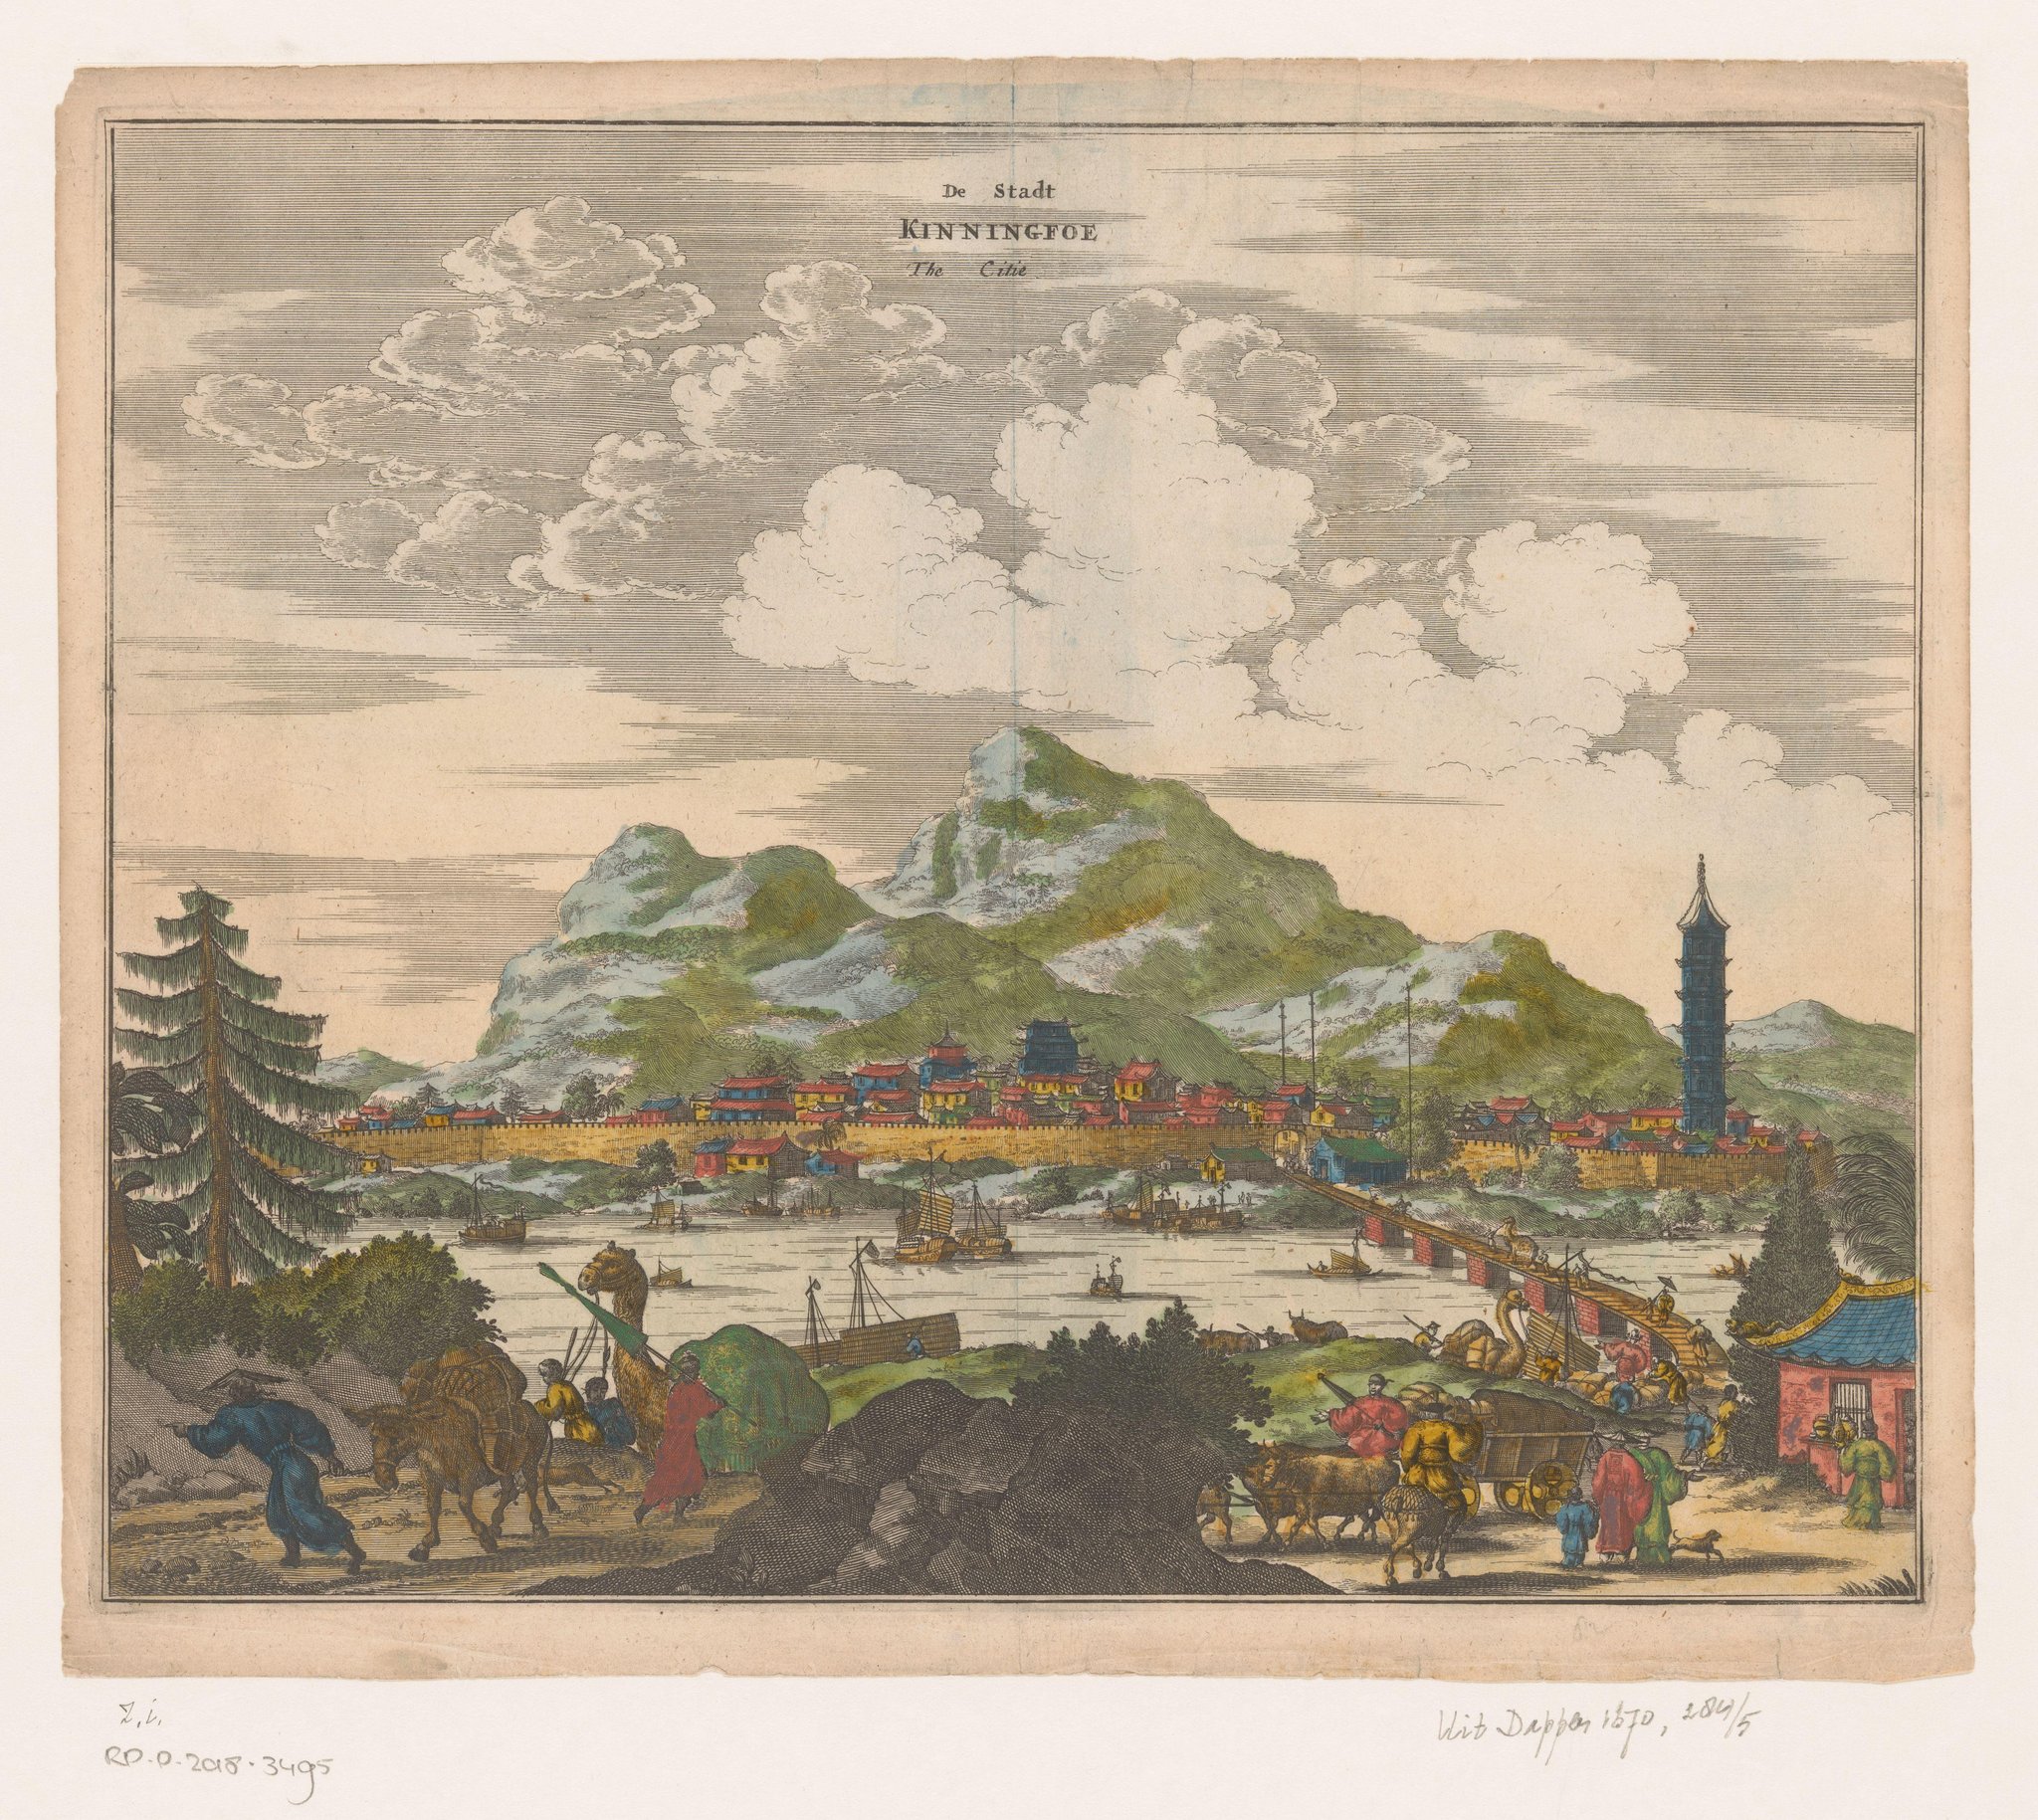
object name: book illustration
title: De stadt Kinningfoe / the Citie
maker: jacob van meurs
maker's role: draughtsman, print maker, publisher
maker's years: 1619-1680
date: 1670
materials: paper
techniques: engraving, hand coloring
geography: amsterdam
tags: prospect of city, town panorama, silhouette of city, china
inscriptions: collector's mark: Lugt 2228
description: Prent uit: Dapper, Olfert. Gedenkwaerdig bedryf der Nederlandsche Oost-Indische Maetschappye, op de kuste en in het keizerrijk van Taising of Sina (...). Amsterdam: Jacob van Meurs, 1670, p. 284-285.